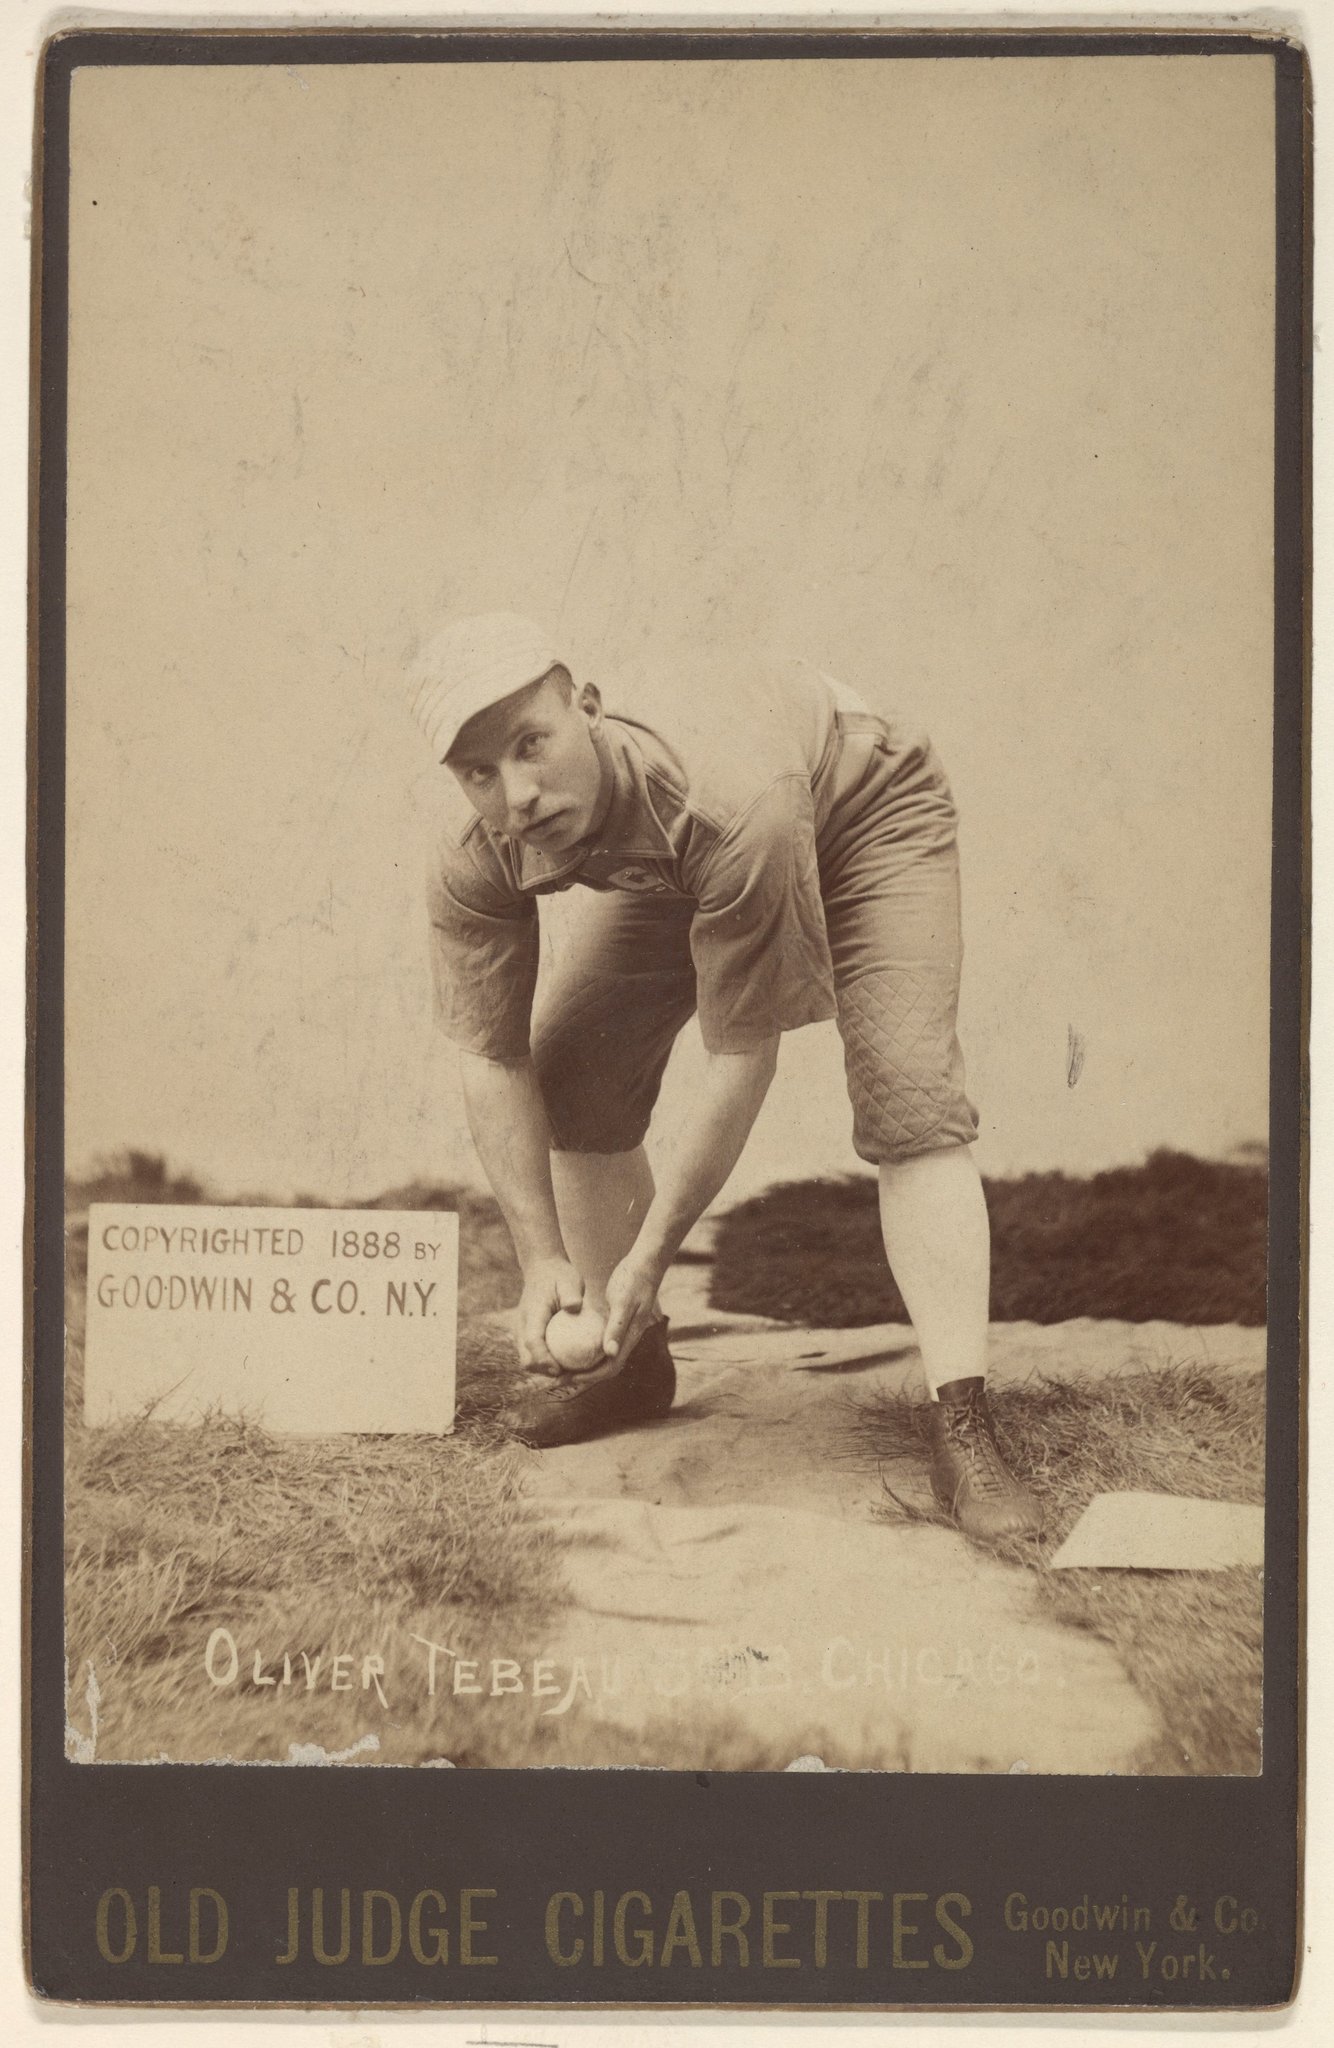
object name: baseball card, photograph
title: Oliver Tebeau, 3rd Base, Chicago, from the series Old Judge Cigarettes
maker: goodwin & company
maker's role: publisher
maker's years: 1850-1950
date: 1888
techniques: albumen silver print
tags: men,portraits,baseball,athletes